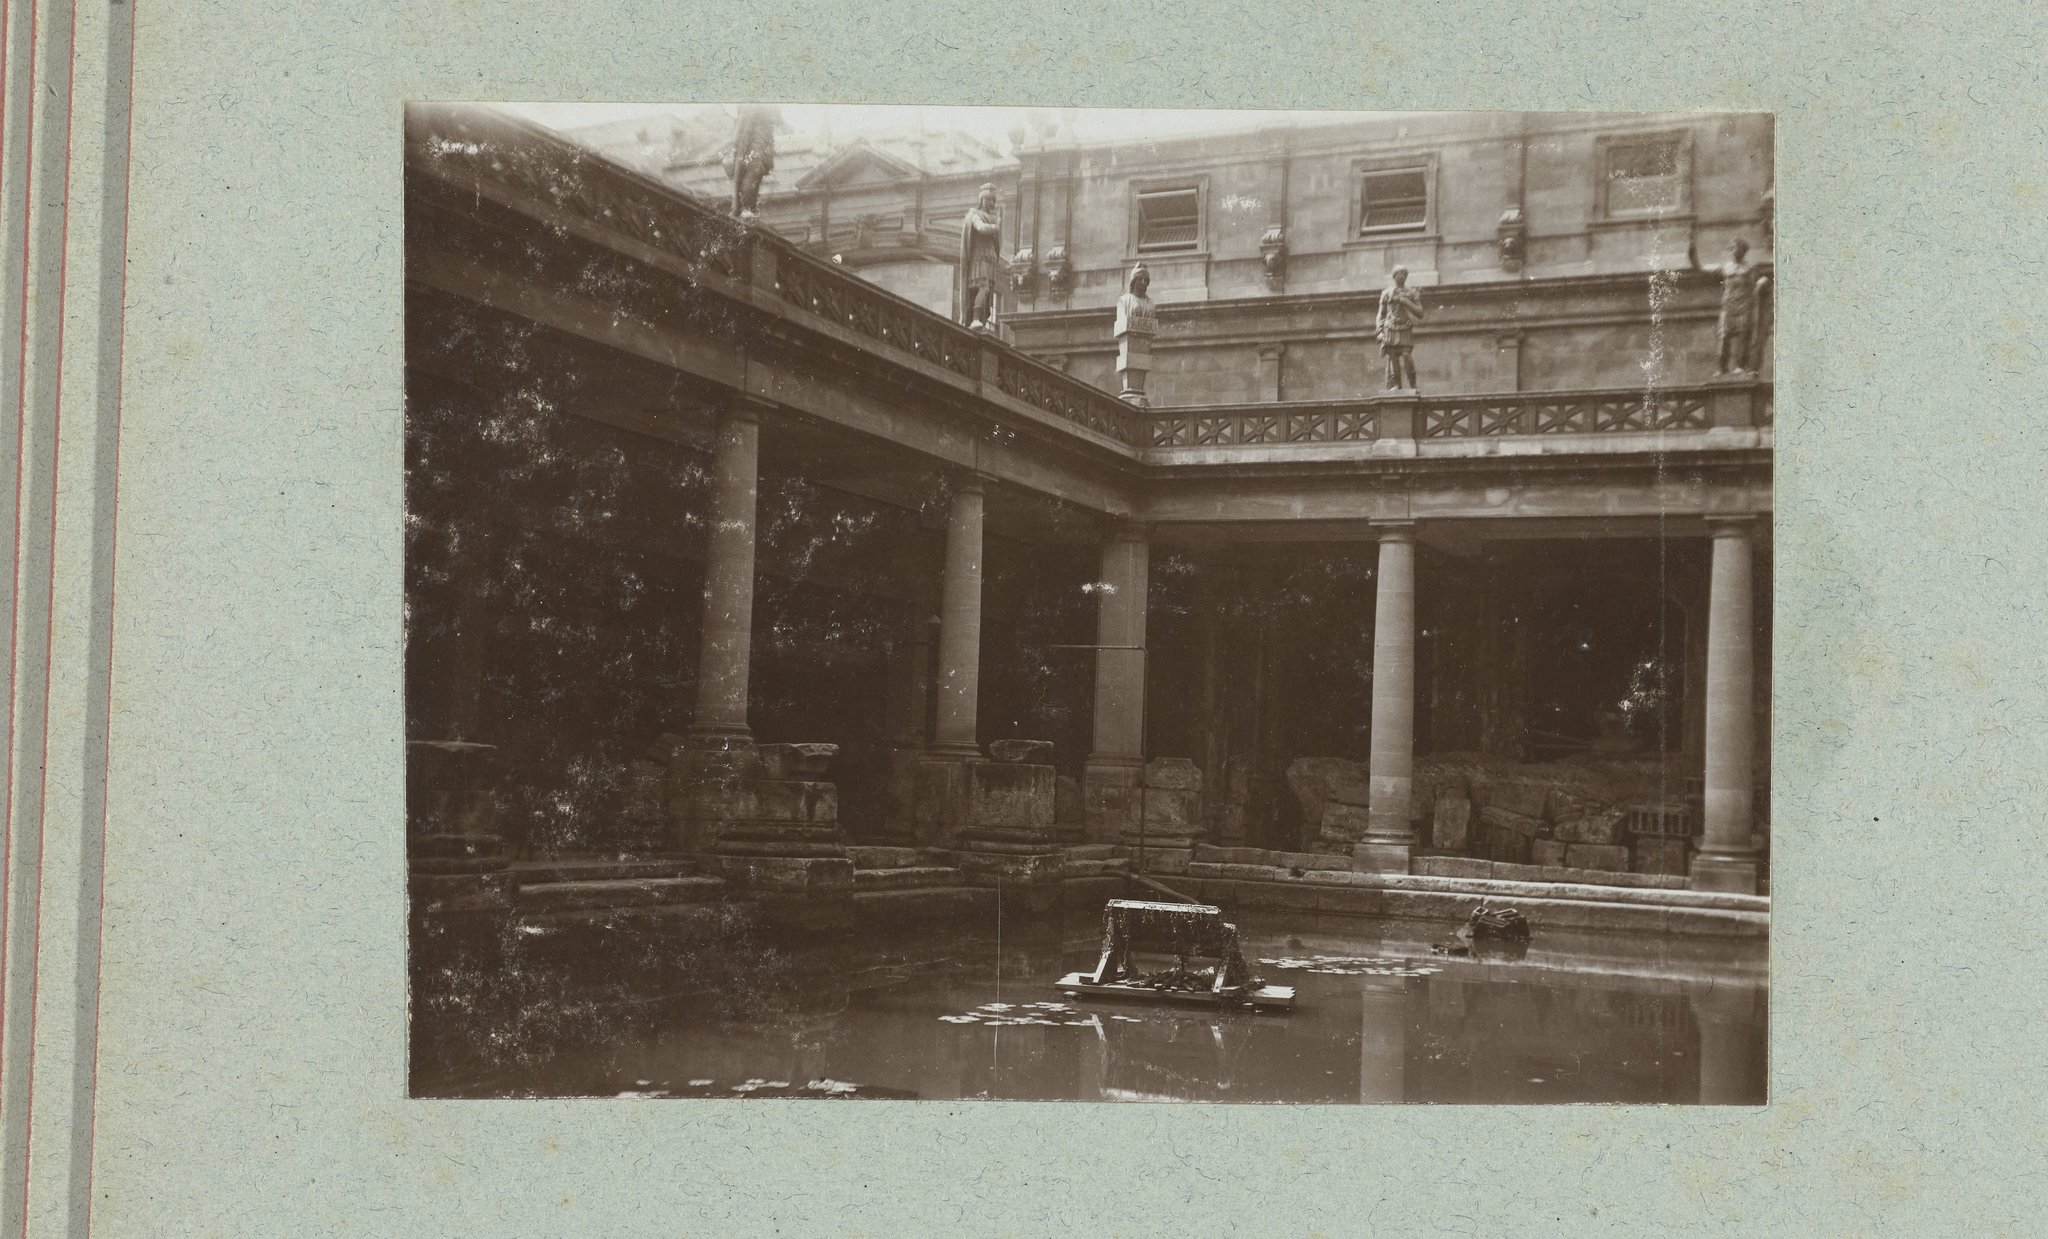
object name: photograph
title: Photographieën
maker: frits freerks fontein fz.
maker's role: fotograaf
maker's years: 1882-1928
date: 1901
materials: cardboard, paper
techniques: gelatin silver print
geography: netherlands